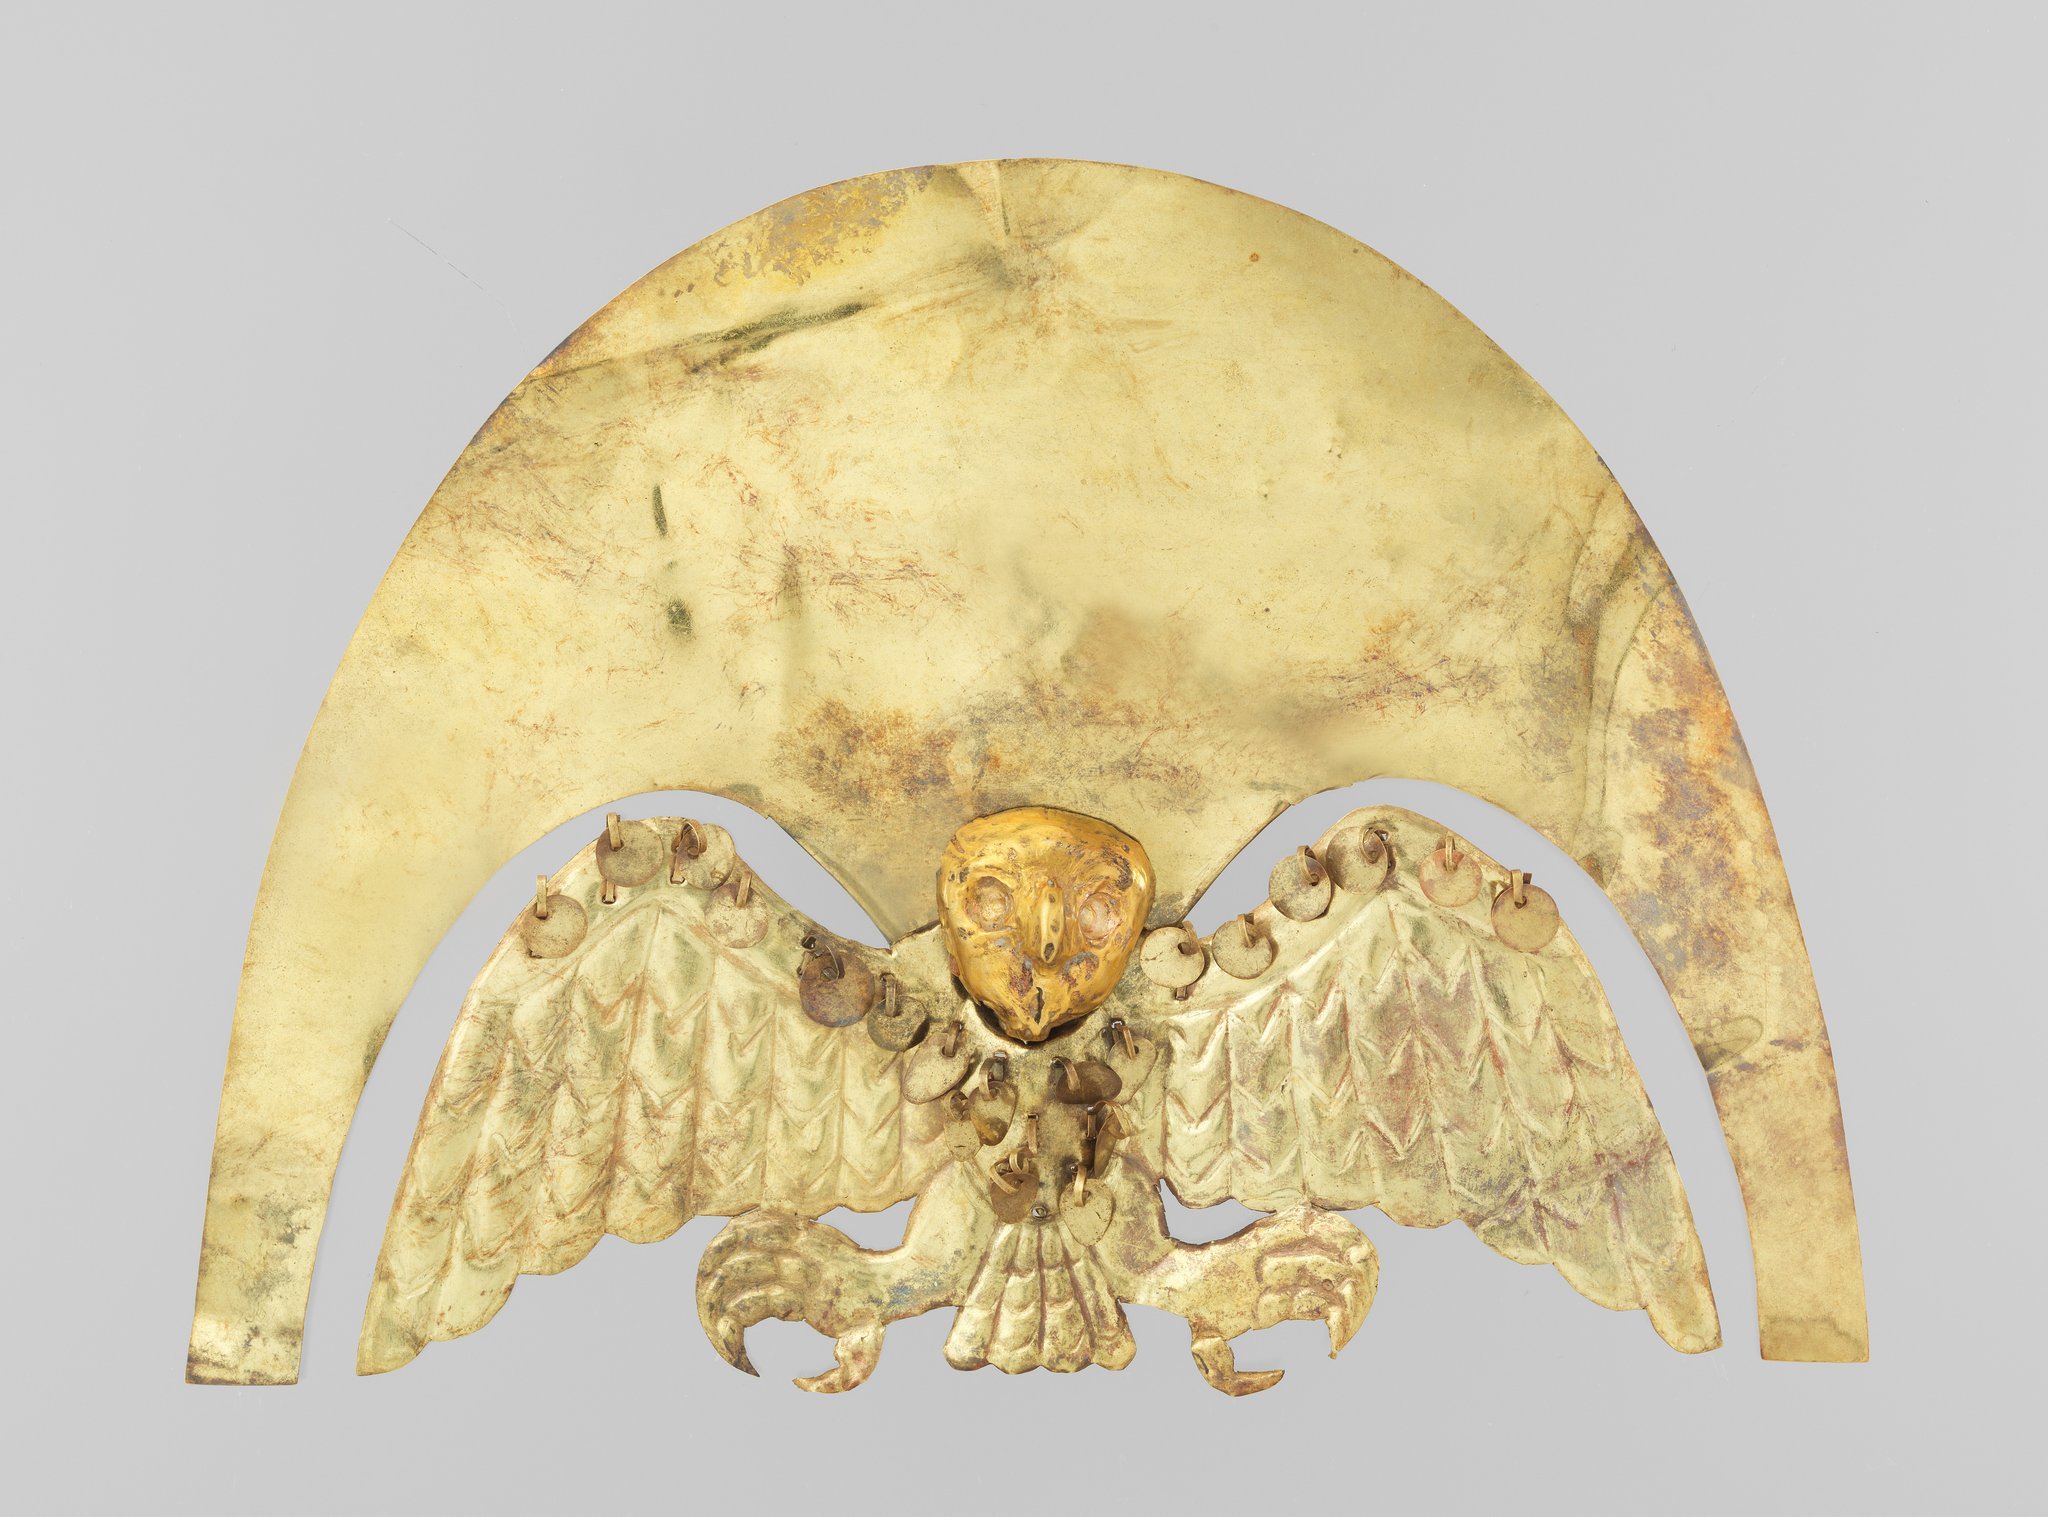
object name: ornament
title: Miniature headdress with owl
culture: moche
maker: moche artist(s)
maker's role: artist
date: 500-800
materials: gold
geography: peru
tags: birds